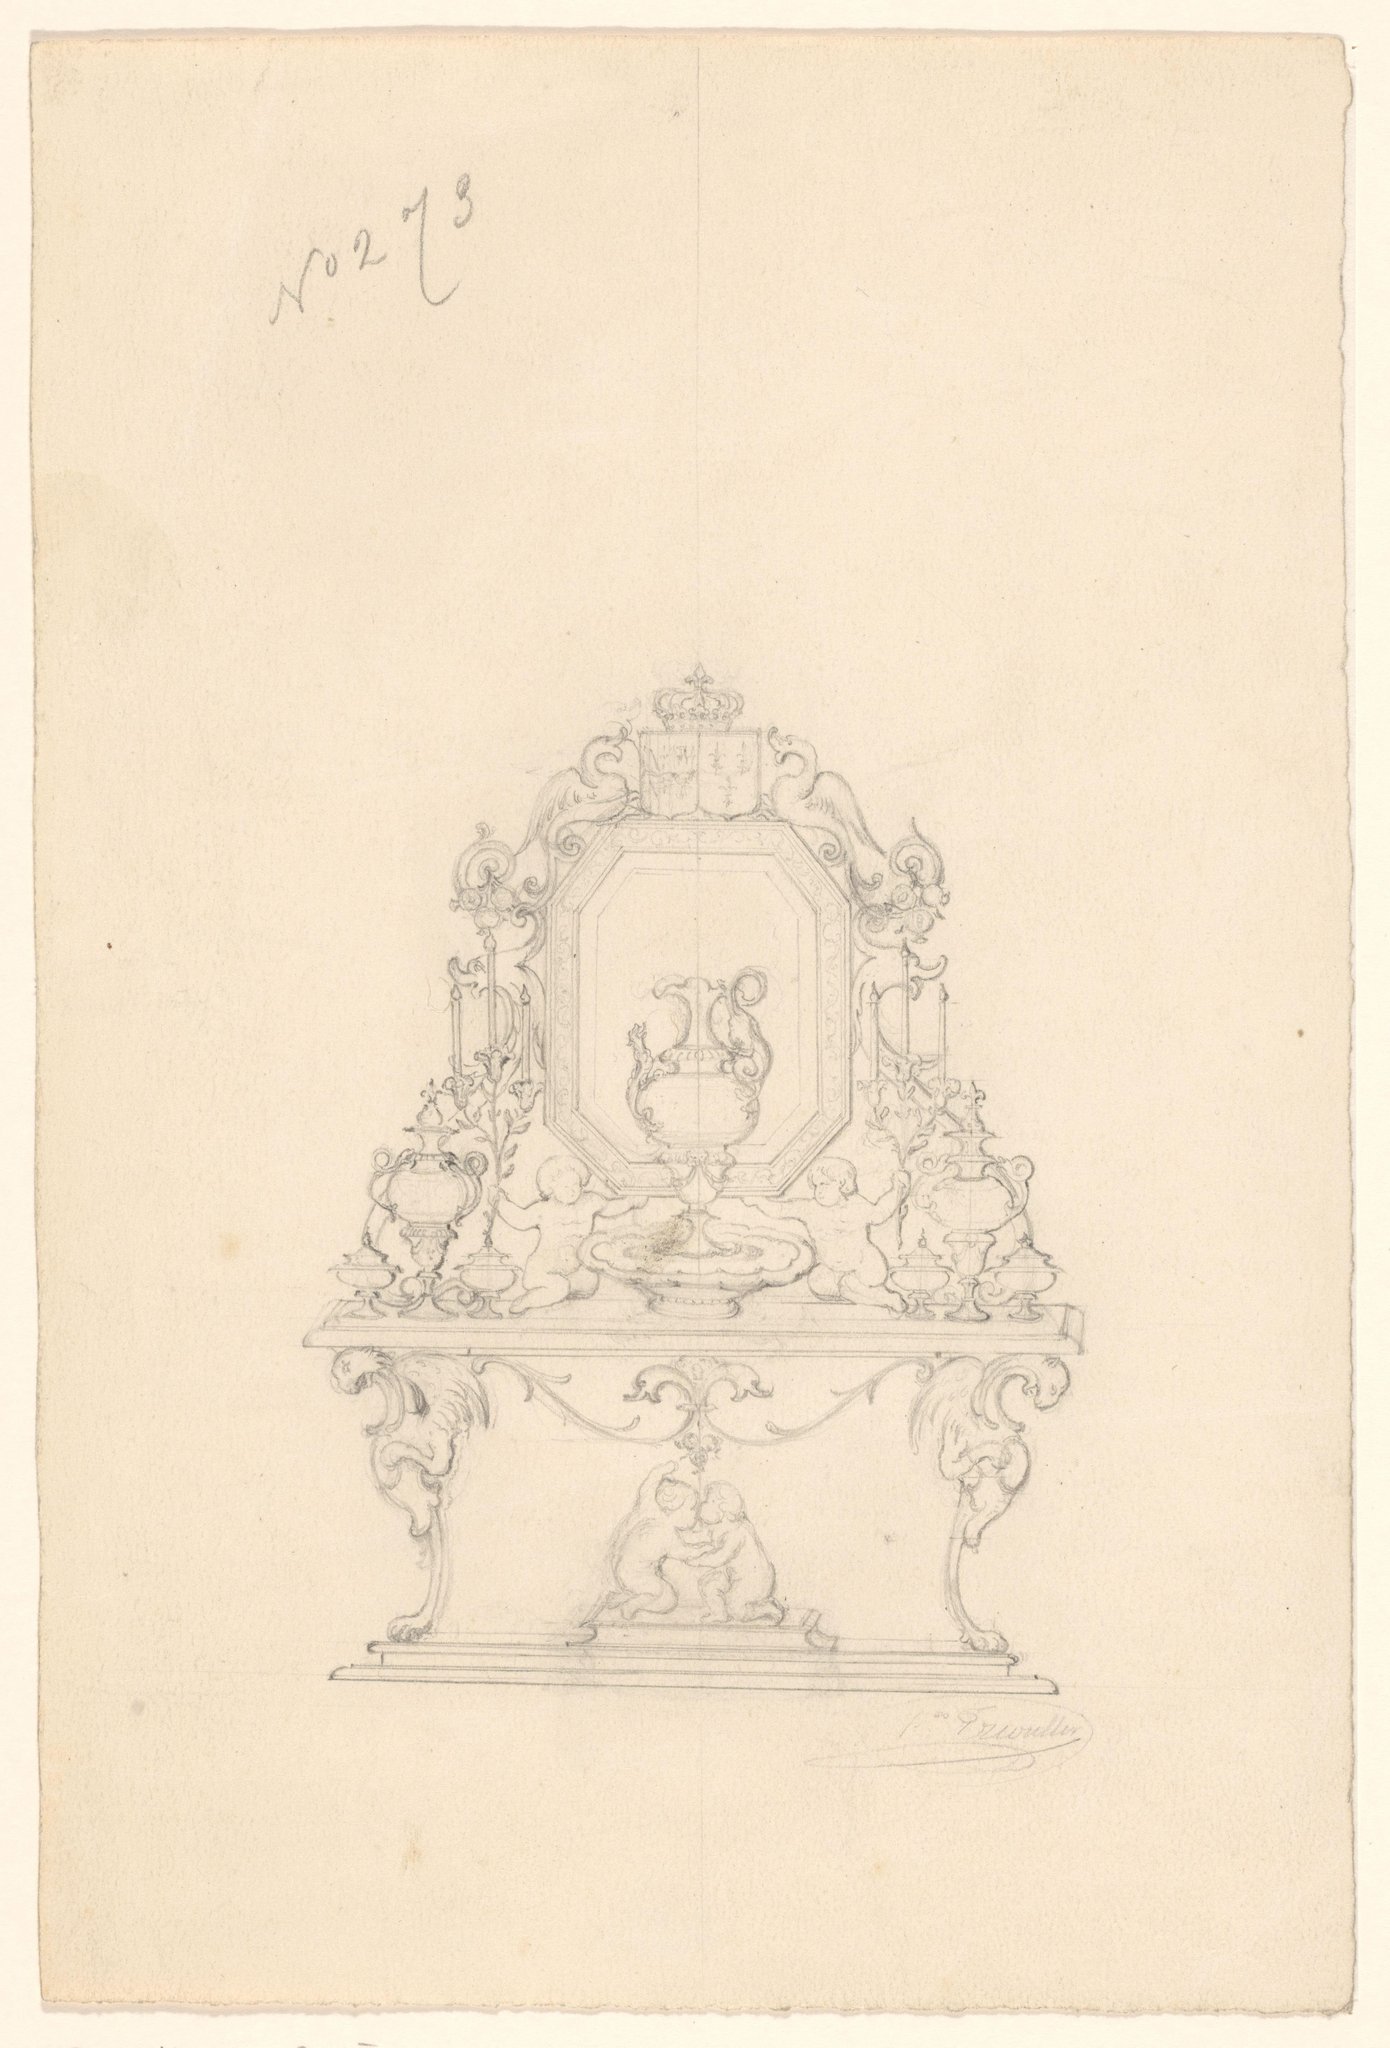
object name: design drawing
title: Ontwerp voor een toilettafel met een spiegel en toebehoren, vermoedelijk voor de hertogin van Parma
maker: charles-eugène trioullier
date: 1845-1848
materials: graphite, paper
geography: paris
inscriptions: signature: ‘Char [?] Triouller’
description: In de bekroning het gekroonde alliantiewapen Parma (?) en Frankrijk.